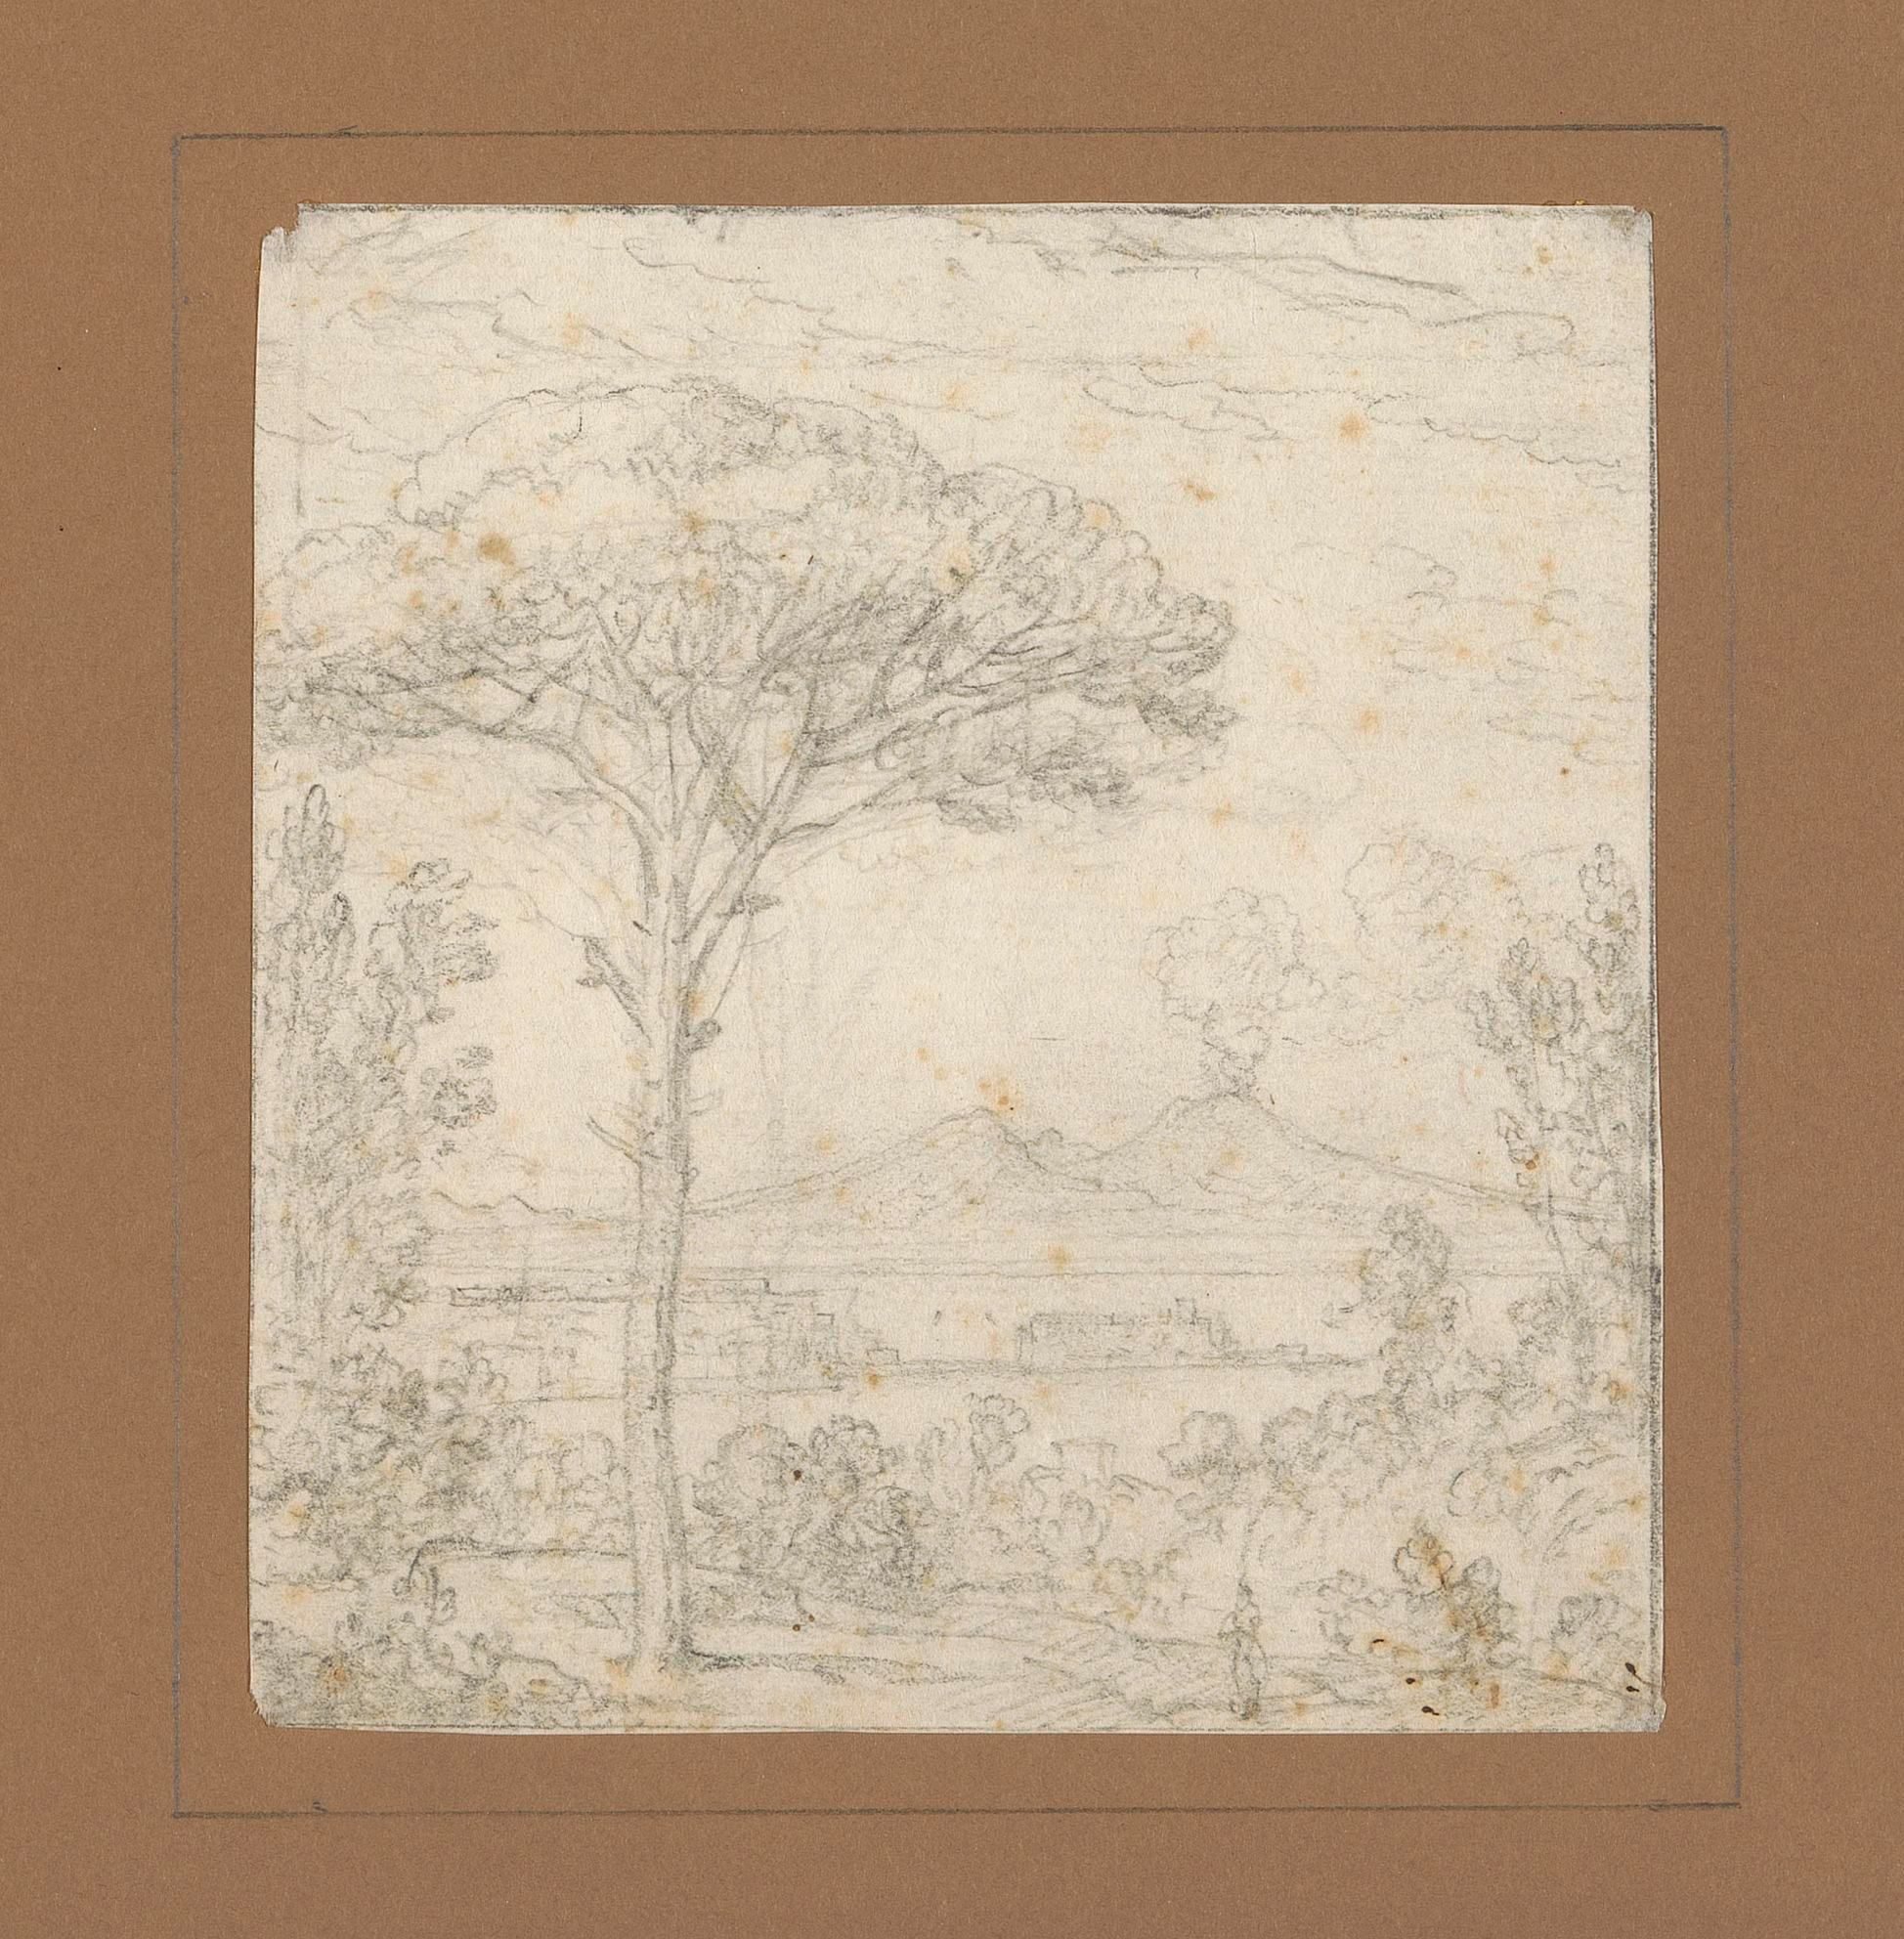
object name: drawing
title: Landschap met boom en in de verte een rokende vulkaan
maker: christoph heinrich kniep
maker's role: draughtsman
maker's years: 1755-1825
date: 1765-1825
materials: paper, pencil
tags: trees, landscapes in the temperate zone, volcano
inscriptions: collector's mark: Lugt 2228